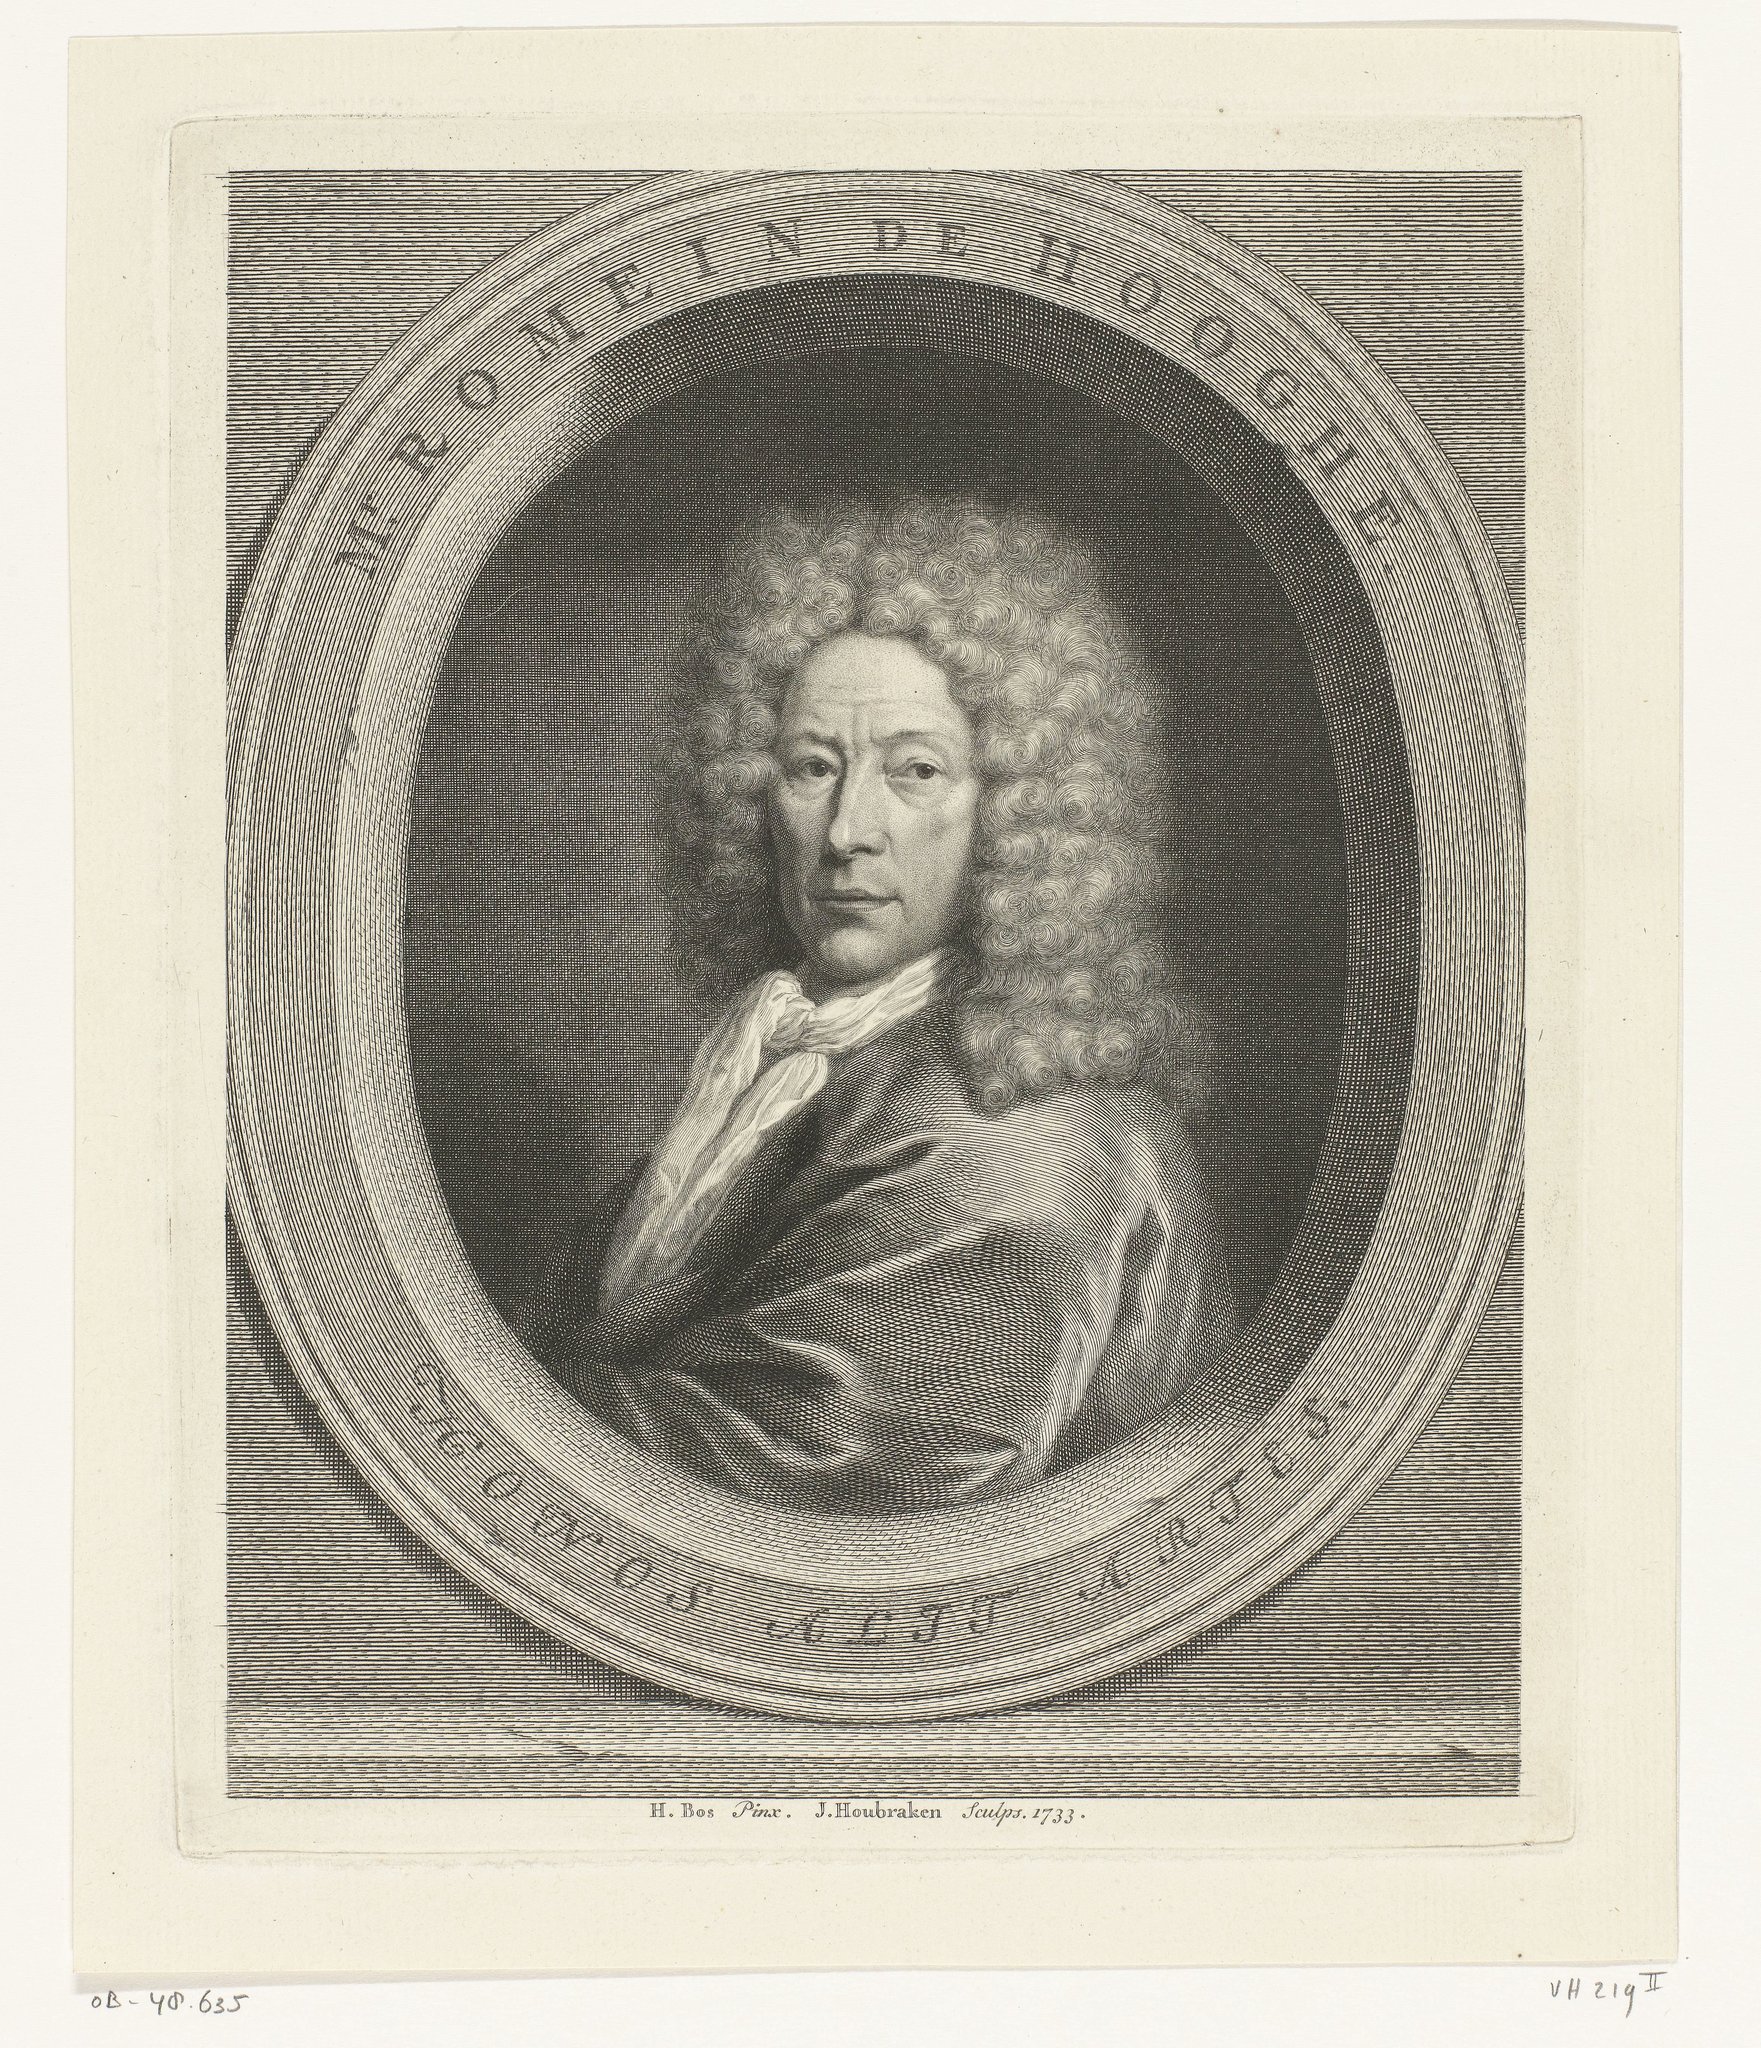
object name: print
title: Portret van Romeyn de Hooghe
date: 1733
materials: paper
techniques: engraving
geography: amsterdam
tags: haarlem, painter, draughtsman, goldsmith, romeyn de hooghe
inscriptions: collector's mark: Lugt 240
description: Buste naar links van Romeyn de Hooghe in een ovale archtectonische omlijsting waarop zijn naam en een regel in het Latijn.